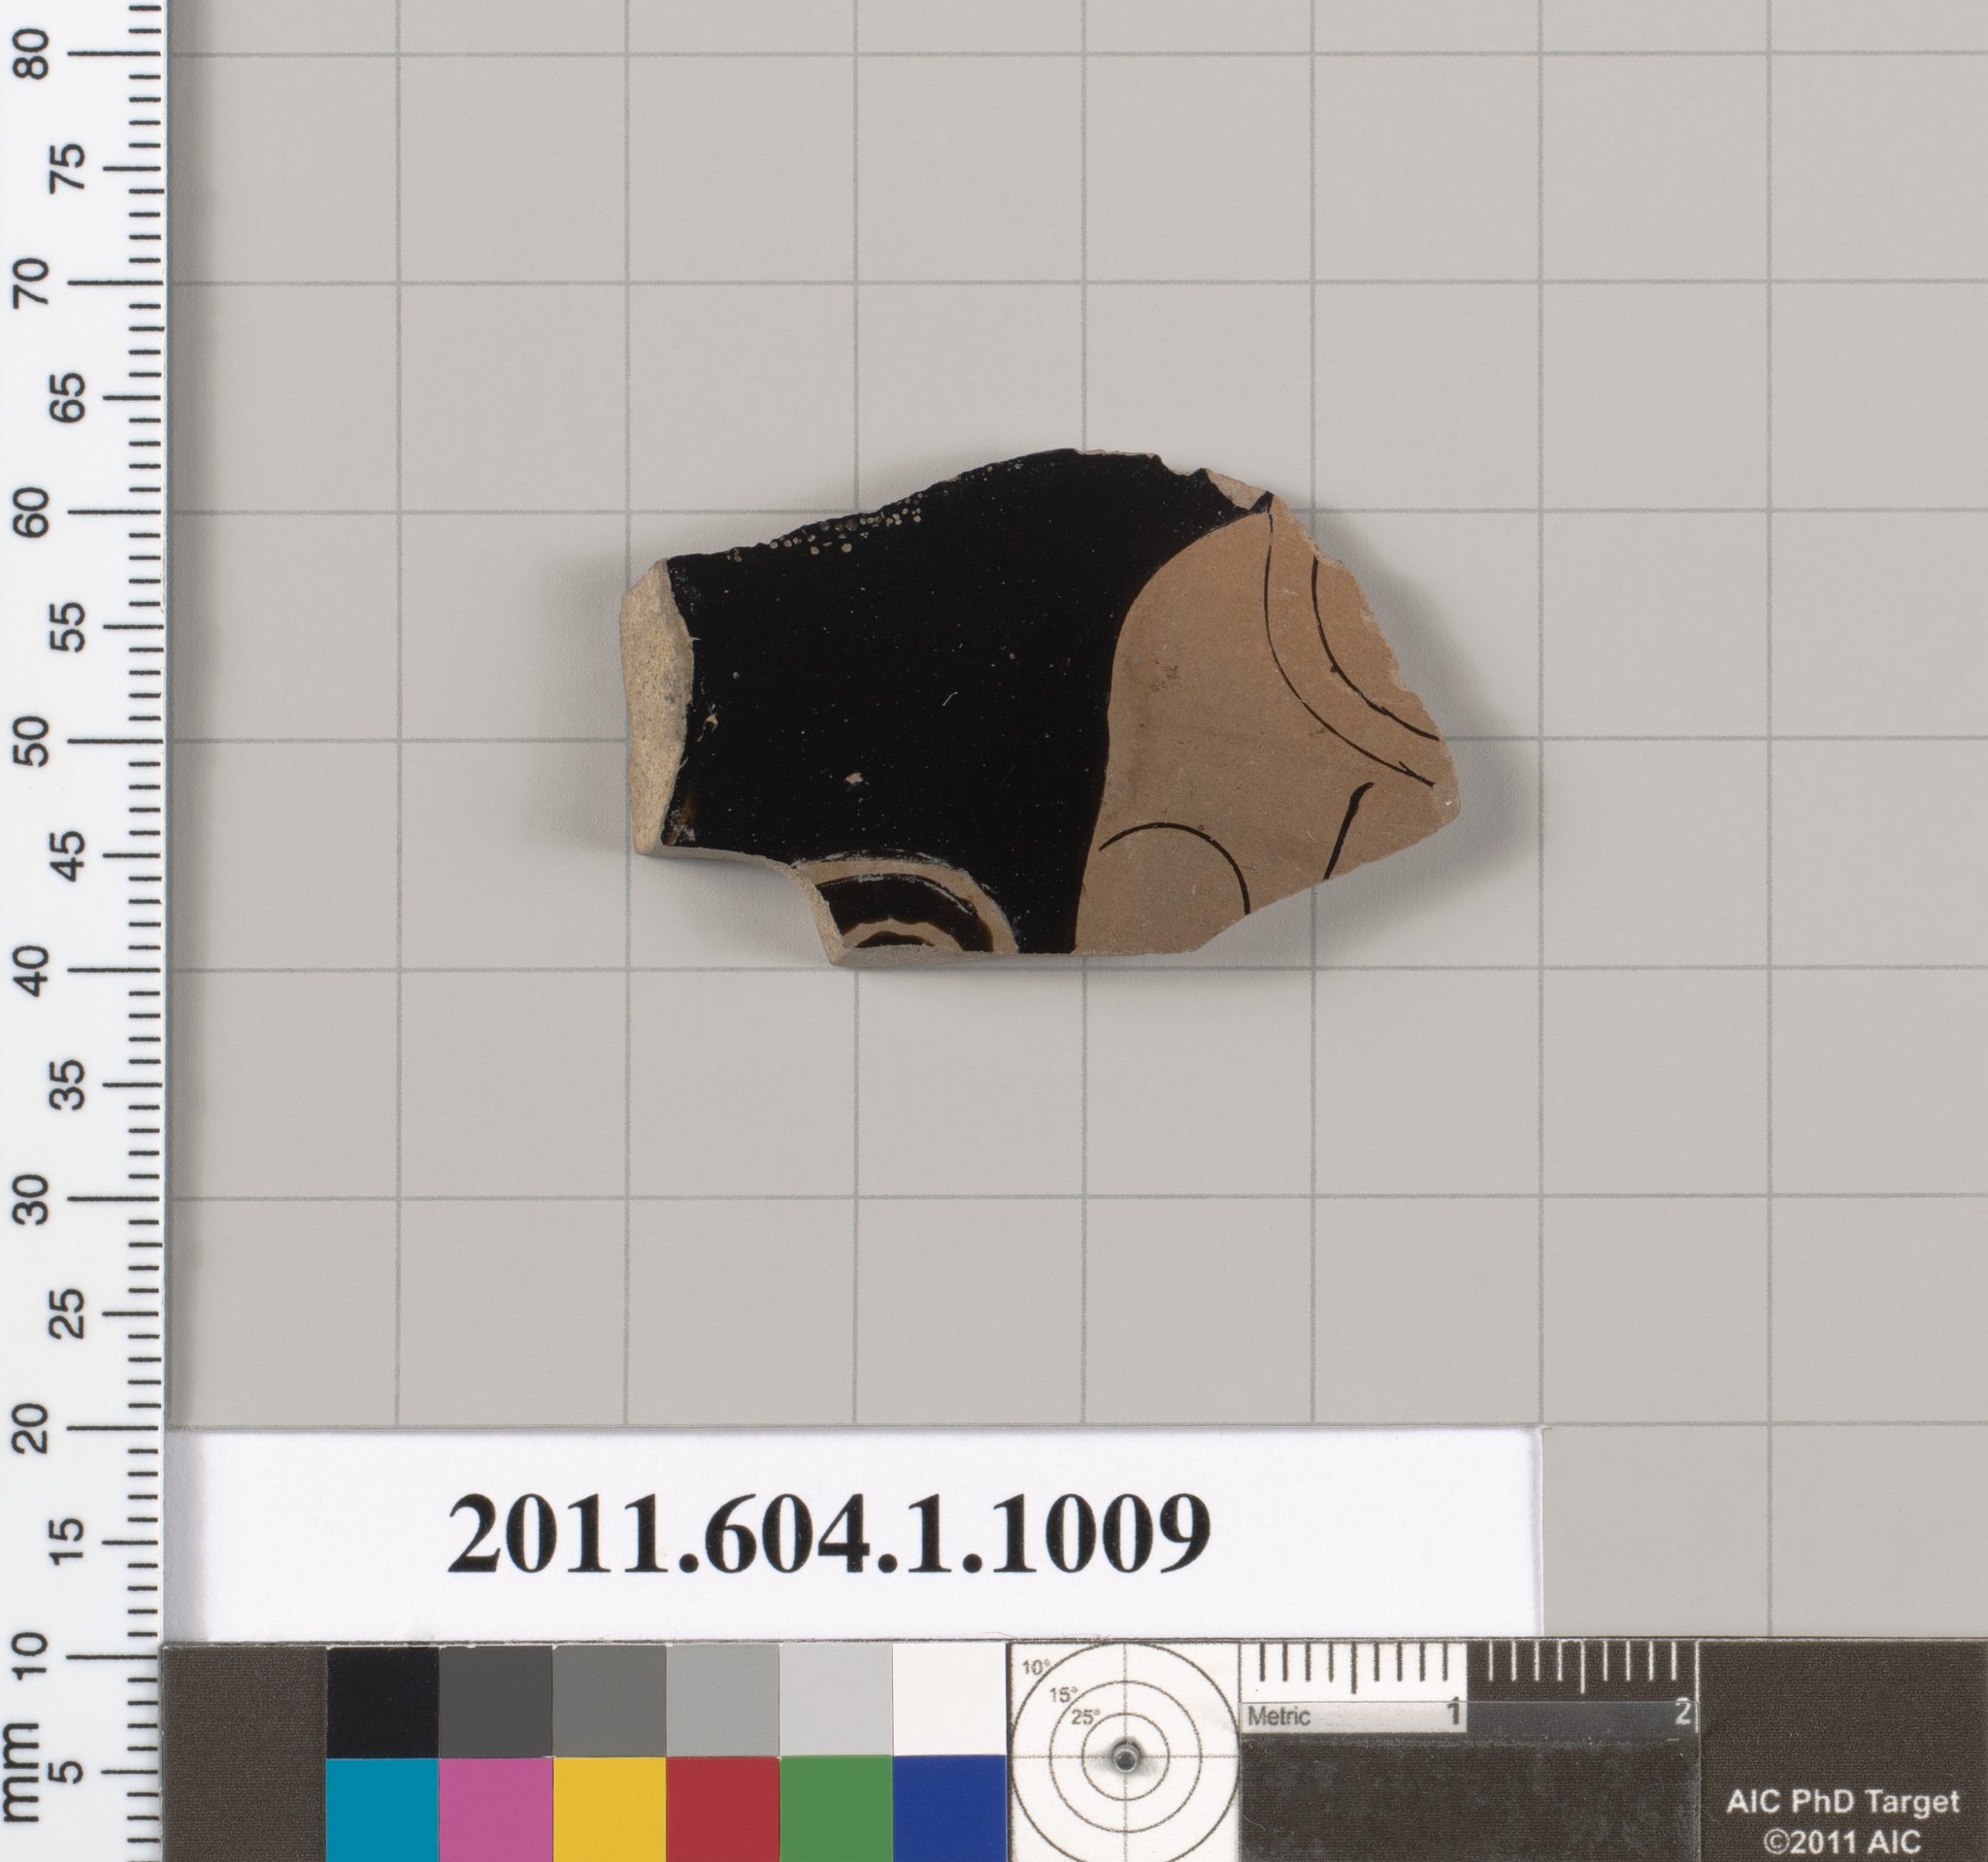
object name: kylix fragment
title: Terracotta fragment of a kylix (drinking cup)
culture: greek, attic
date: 475-451 BCE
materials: terracotta